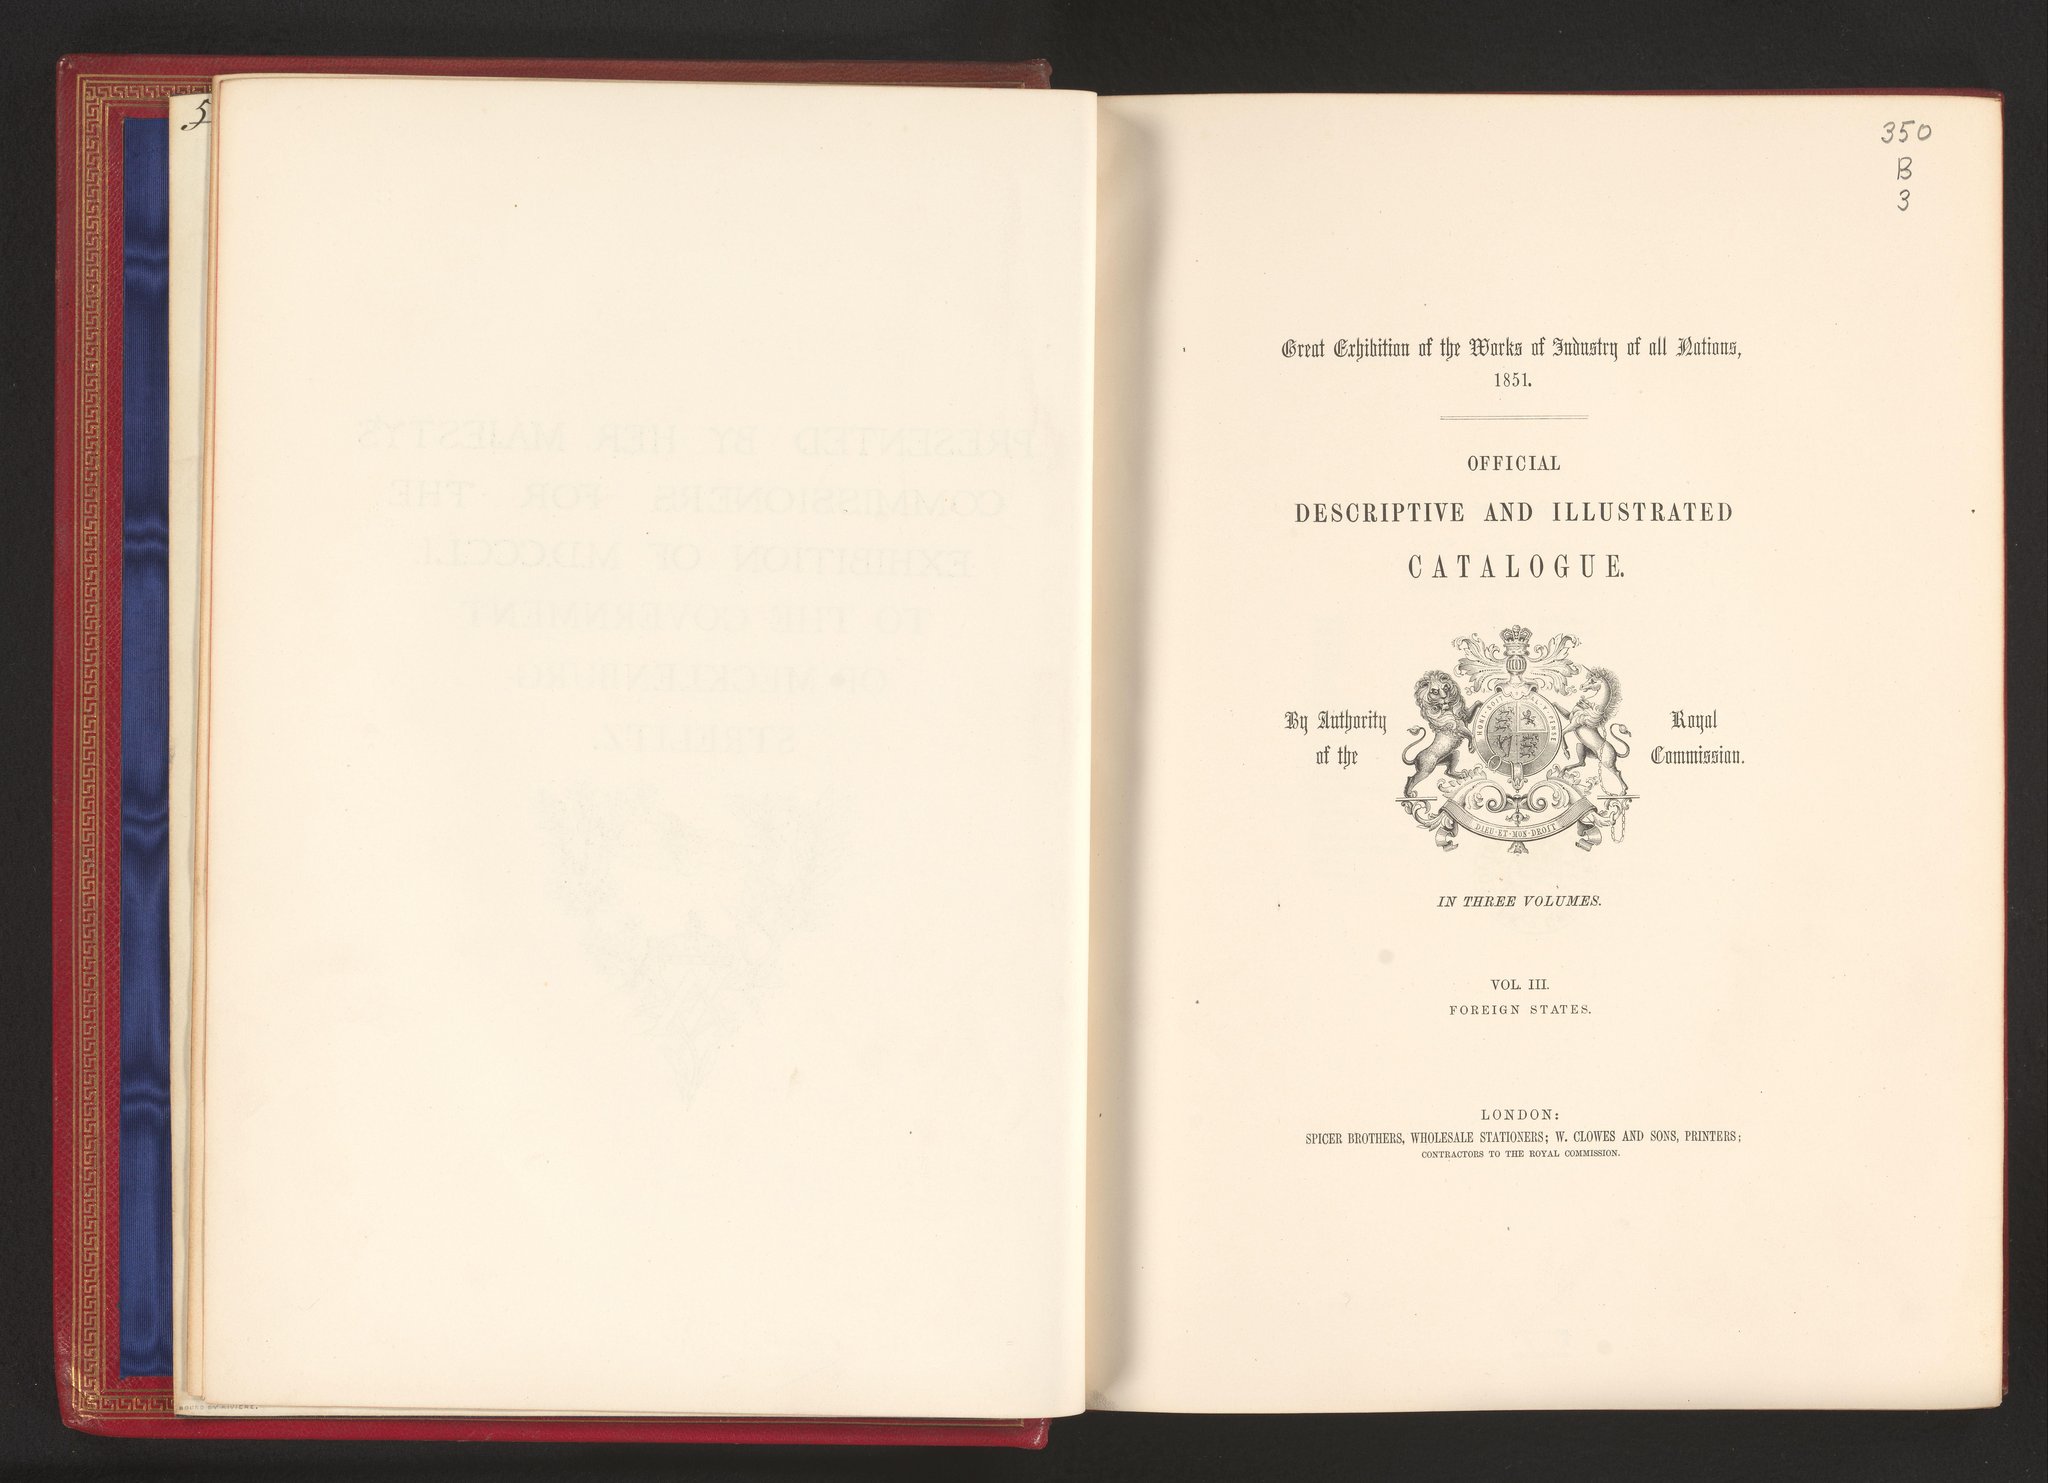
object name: book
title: Great exhibition of the works of industry of all nations 1851: official descriptive and illustrated catalogue - vol. III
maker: robert riviere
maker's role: boekbinder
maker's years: 1808-1882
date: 1851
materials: cardboard, leather, paper, silk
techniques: engraving, letterpress printing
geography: london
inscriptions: stamp: ‘Abgegeben an/ Norddeutsches/ Antiquariat’, inscription: ‘593, d. [doorgestreept]/ 10.’, stamp: ‘Grosherzorgliche Bibliothek/ Neustrelitz’